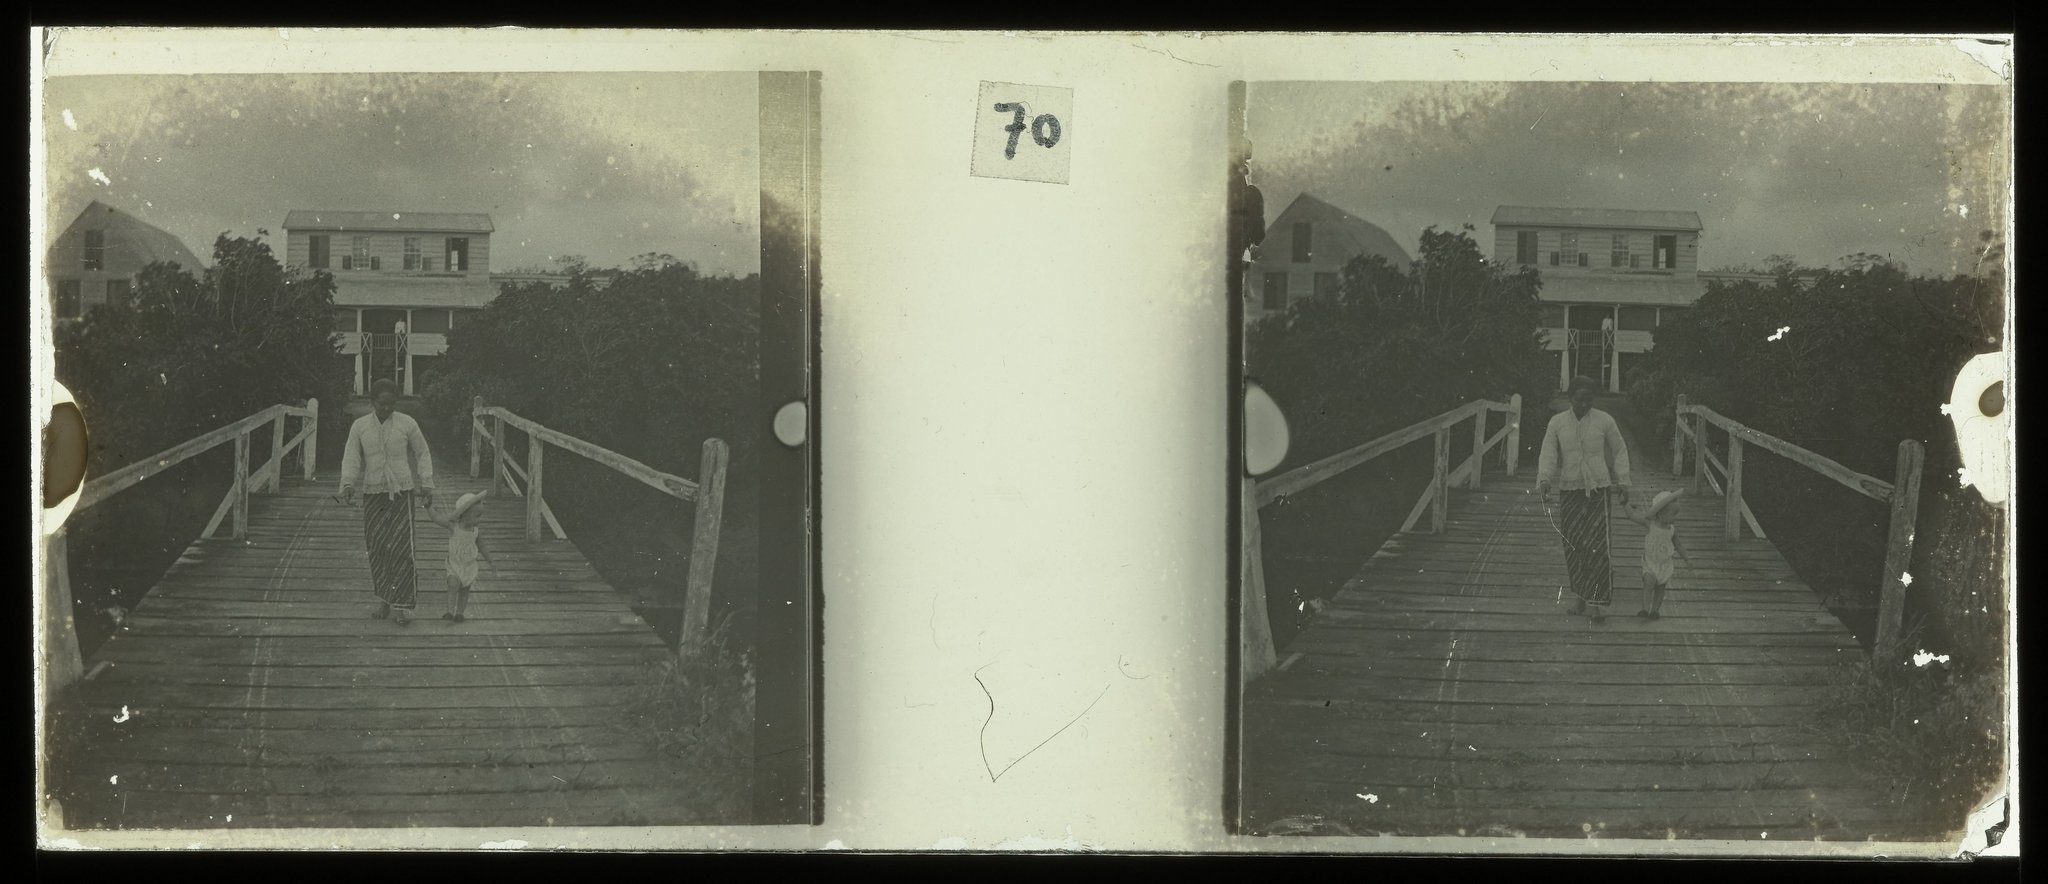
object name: stereograph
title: Plantage Accaribo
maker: theodoor brouwers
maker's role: amateurfotograaf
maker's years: 1874-1932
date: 1913-1930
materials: glass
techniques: photography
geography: suriname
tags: amsterdam, theodoor brouwers, plantation, suriname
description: In de periode 1911-1932 woonde op plantage Accaribo in Suriname de familie Brouwers van wie de foto's afkomstig zijn. Rond 1910 vond Theodoor Brouwers werk op plantage Accaribo. In 1929 werd hij eigenaar van de plantage. Op Accaribo werden in zijn tijd bananen geproduceerd en wat koffie.